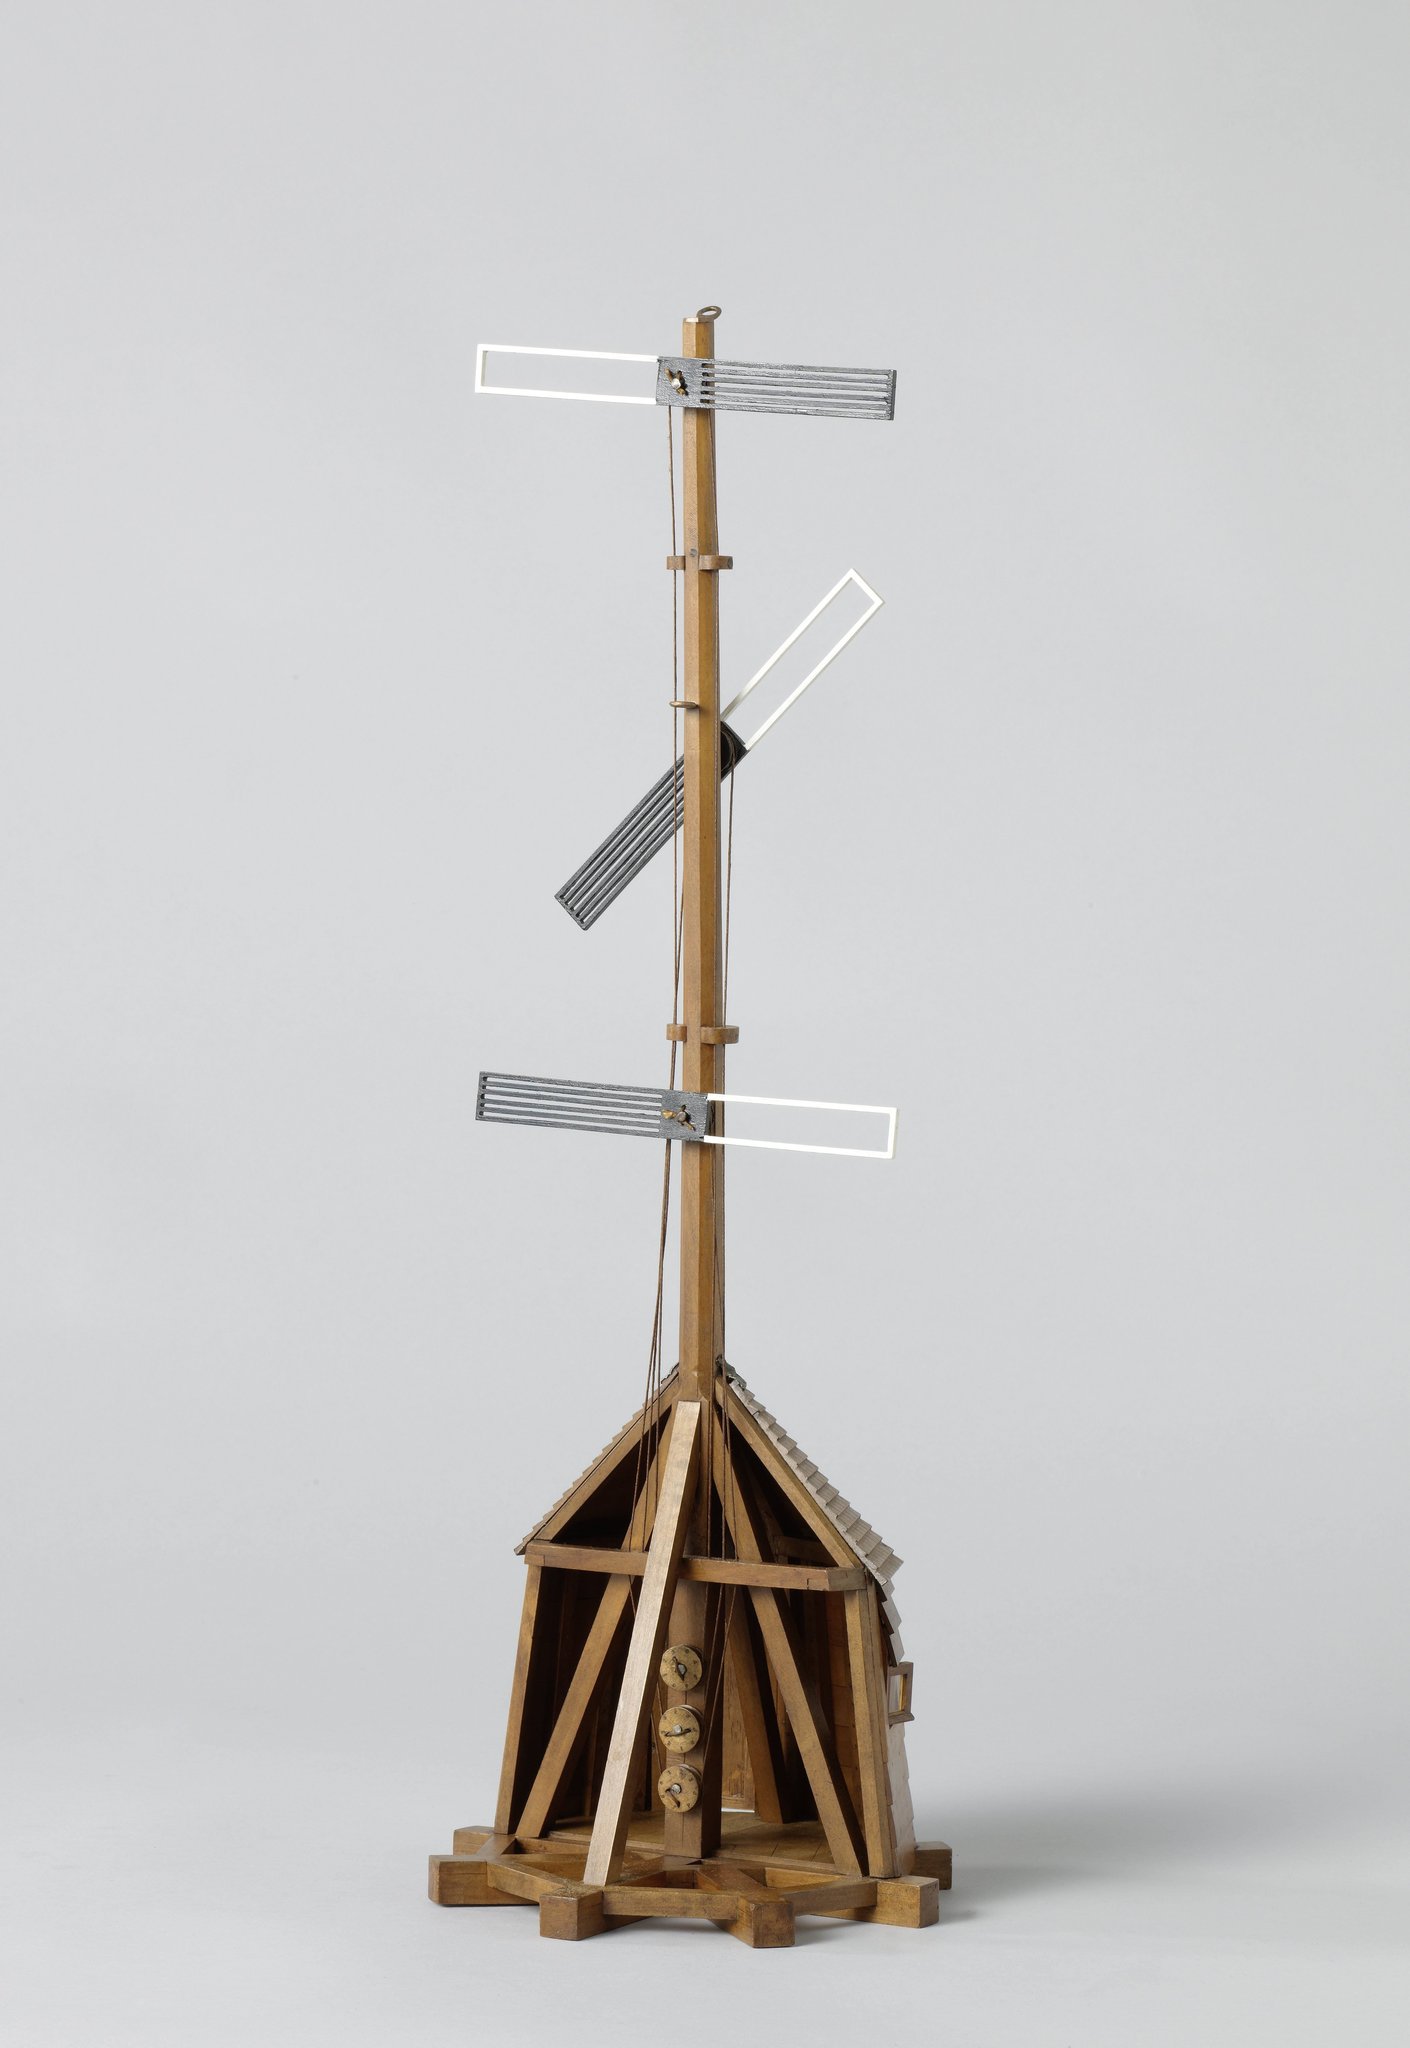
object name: demonstration model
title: Model of an Optical Telegraph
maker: Anonymous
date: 1800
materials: glass, iron, lead, fiber, wood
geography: france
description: Model van een optische telegraaf op achtkantige voet. De telegraaf bestaat uit een mast met drie draaibare armen; deze bestaan uit een latwerk om hun gewicht laag te houden, en zijn aan de ene kant zwart, aan de andere kant, die alleen als tegenwicht dient, wit en opengewerkt, zodat dit eind op afstand praktisch onzichtbaar is. Elke arm heeft zes standen. Op de voet is een halve achtkantige hut met puntdak gebouwd, dat de binnenzijde en de werking van het seinmechaniek laat zien.